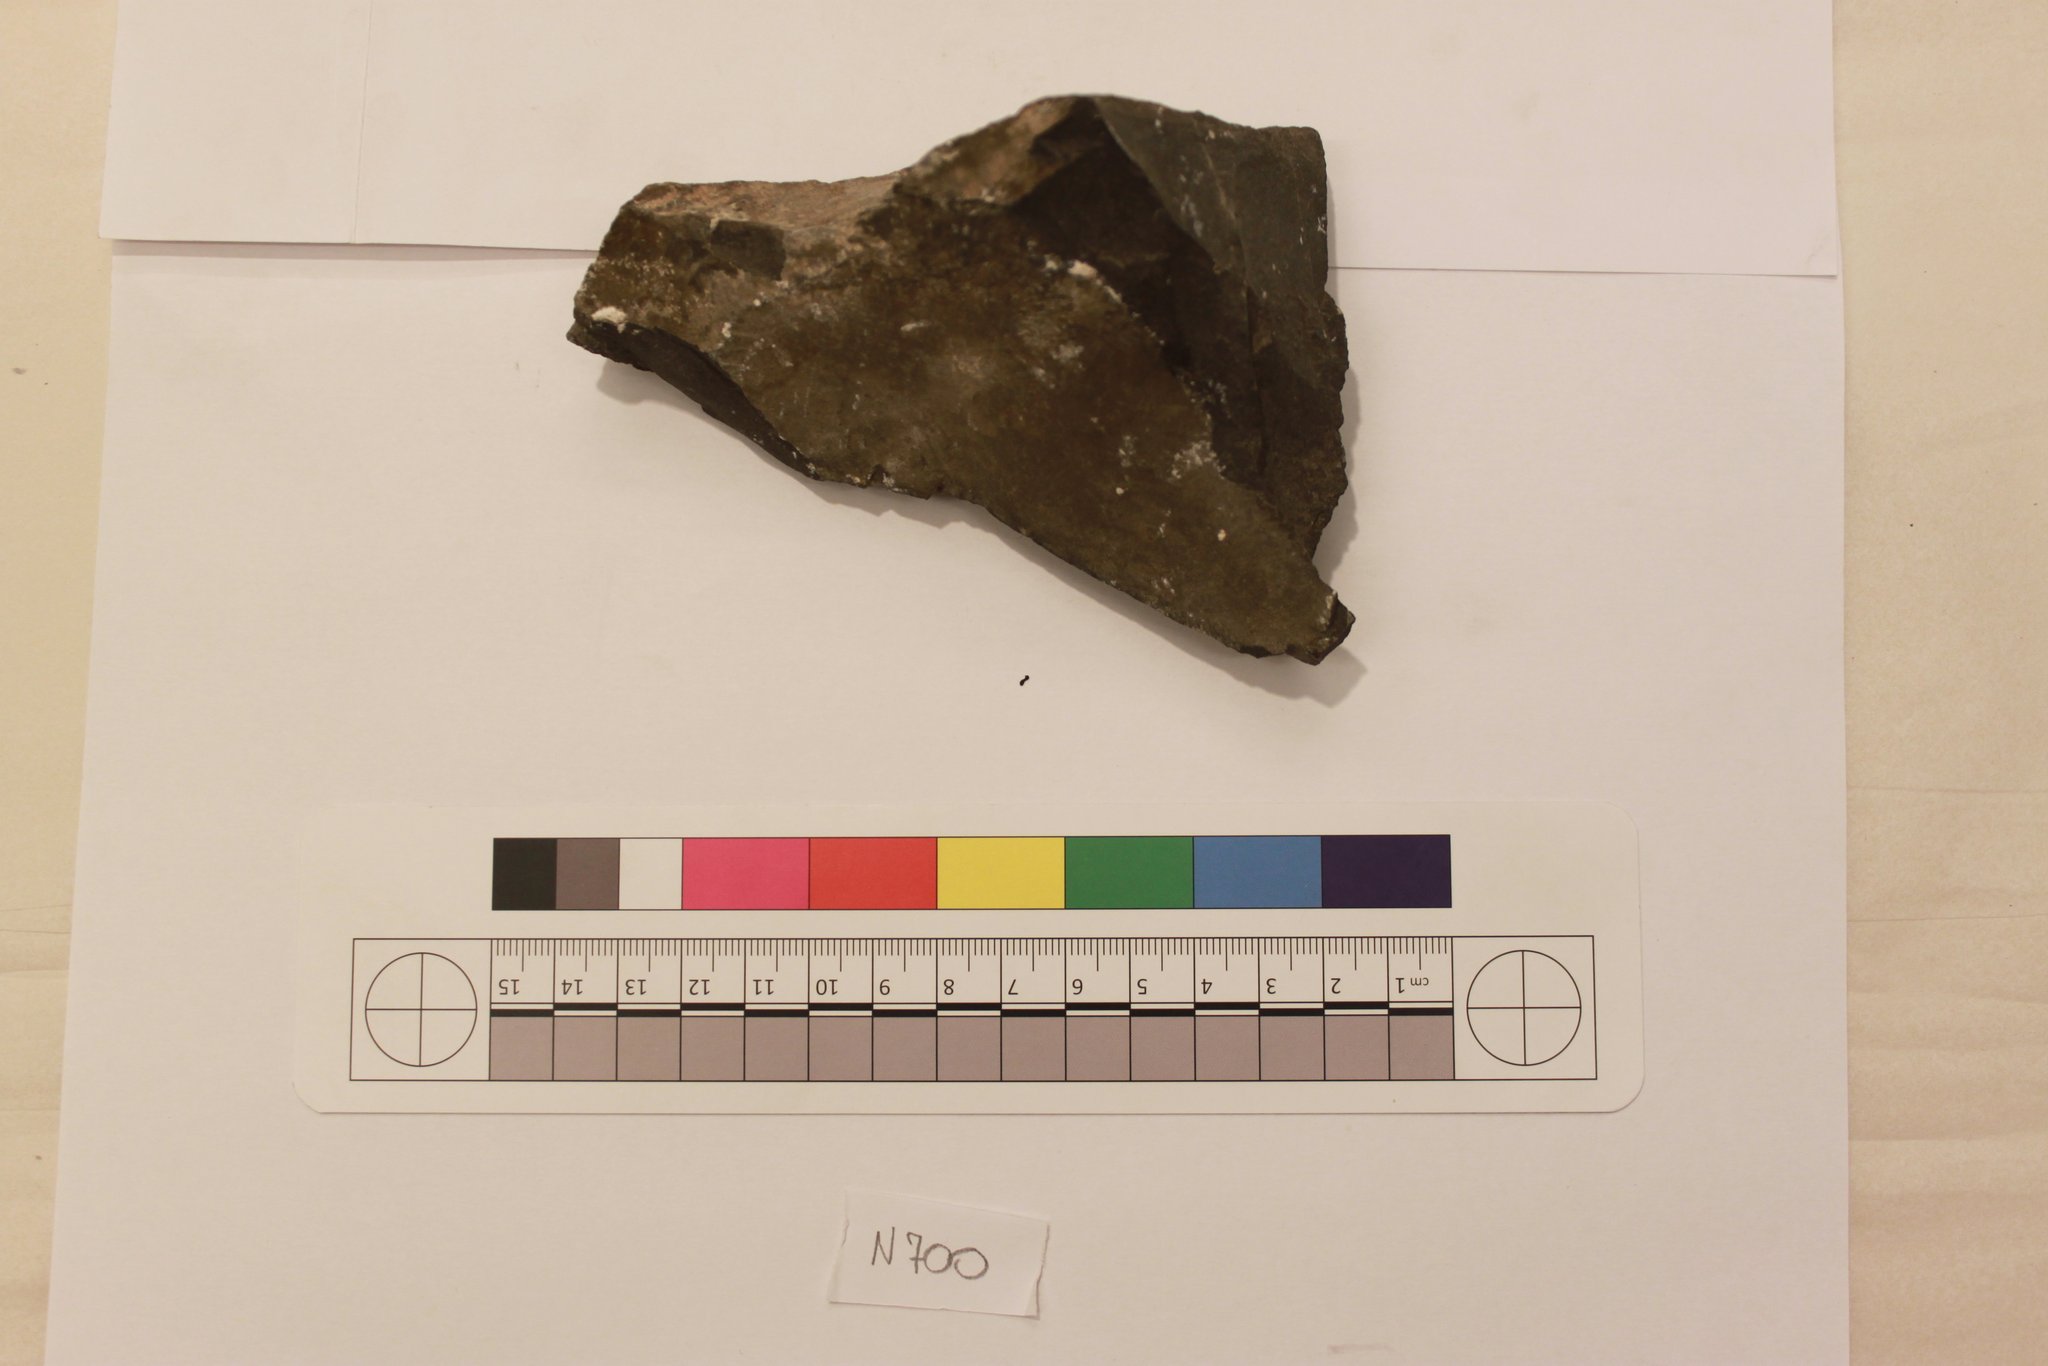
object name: fragment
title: Stucco Fragment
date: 701-1200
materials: stone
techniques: carving, painting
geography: iran